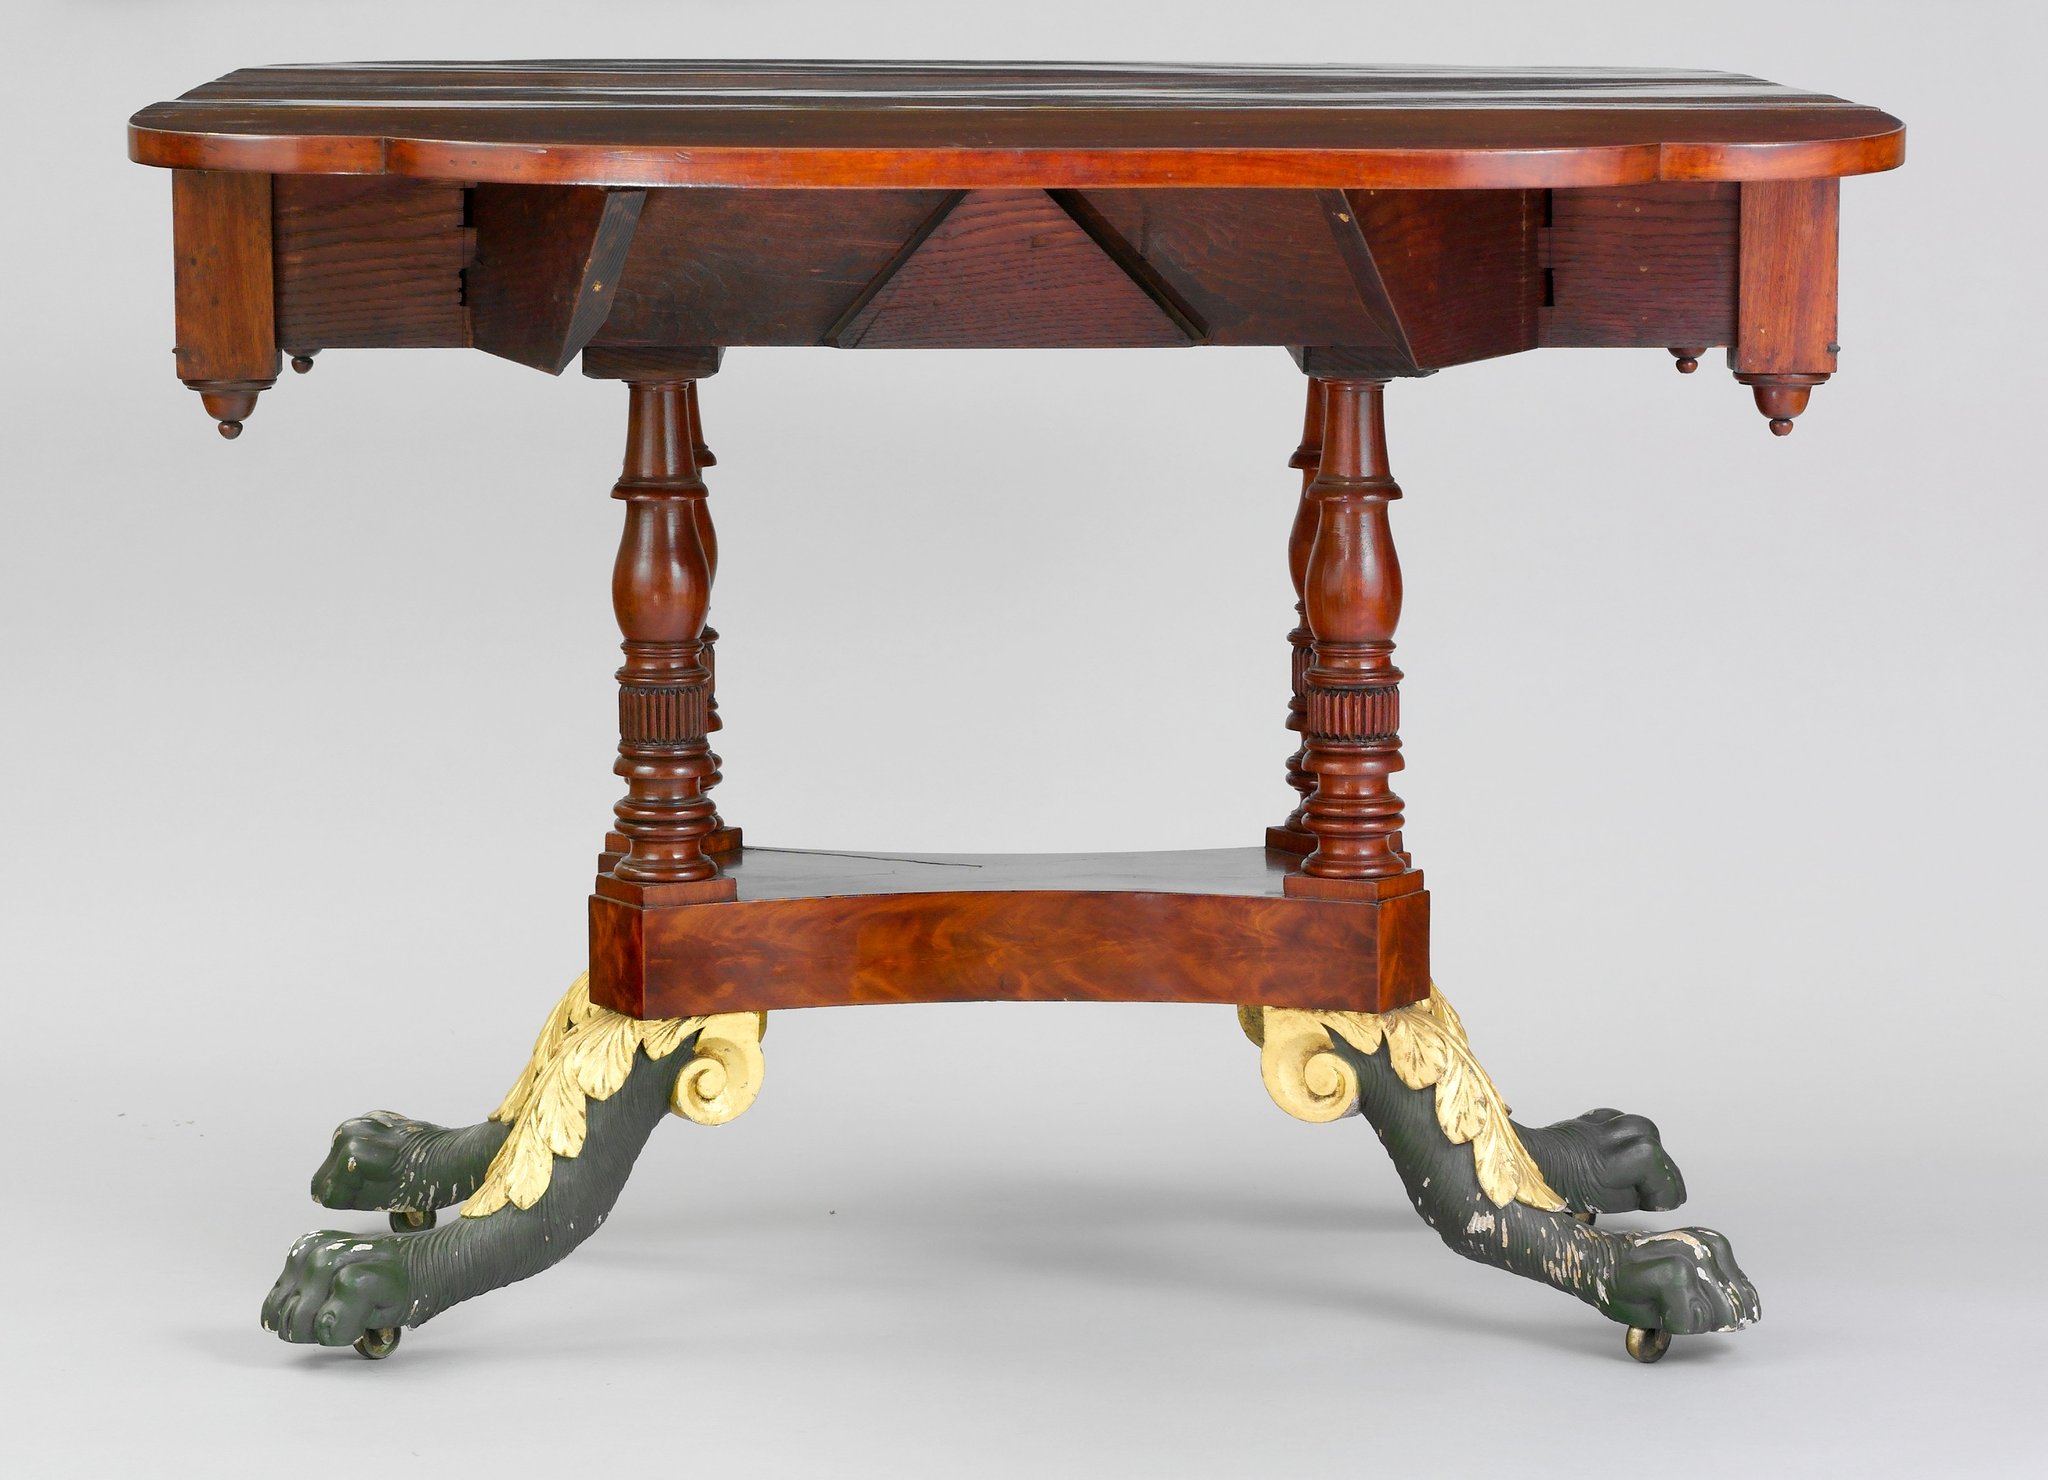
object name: drop leaf table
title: Drop-leaf Table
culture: american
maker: michael allison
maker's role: maker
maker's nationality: american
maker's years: 1773-1855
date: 1817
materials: wood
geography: united states